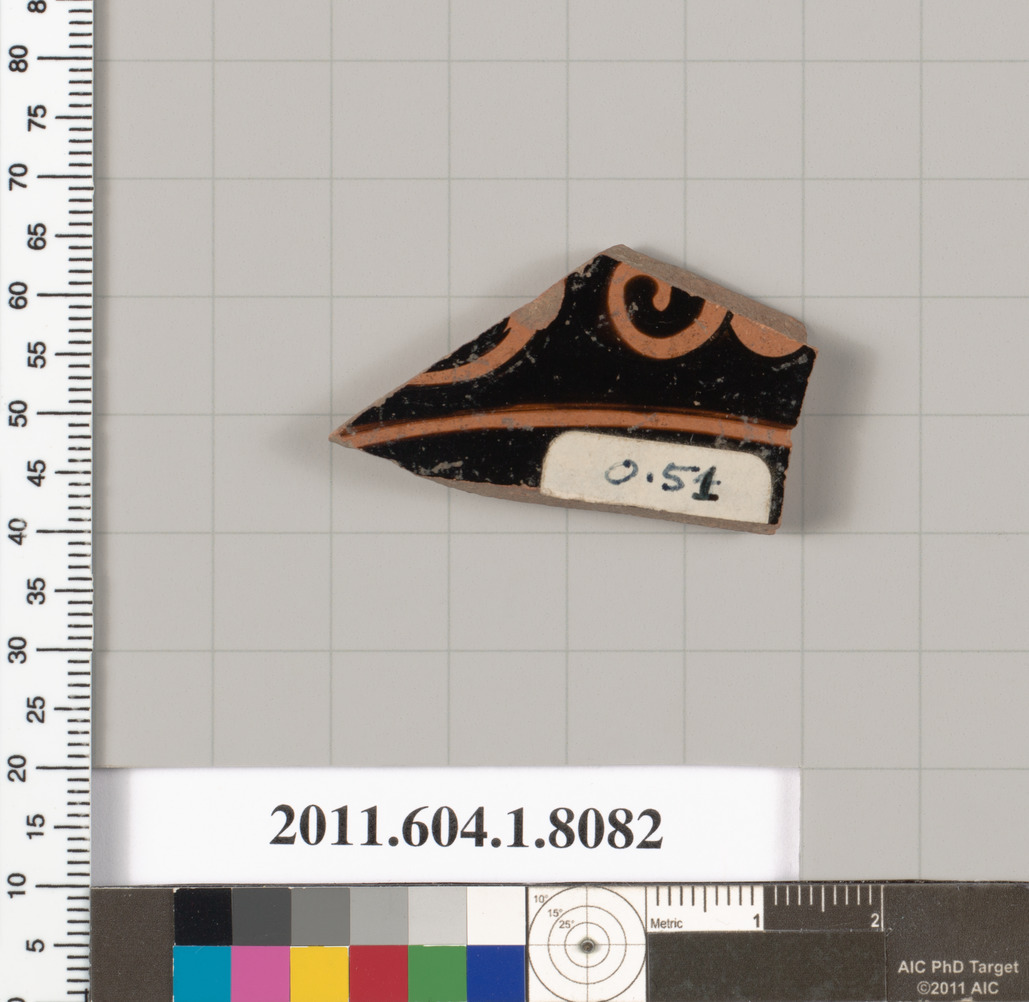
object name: kylix fragment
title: Terracotta fragment of a kylix (drinking cup)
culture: greek, attic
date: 510-500 BCE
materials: terracotta